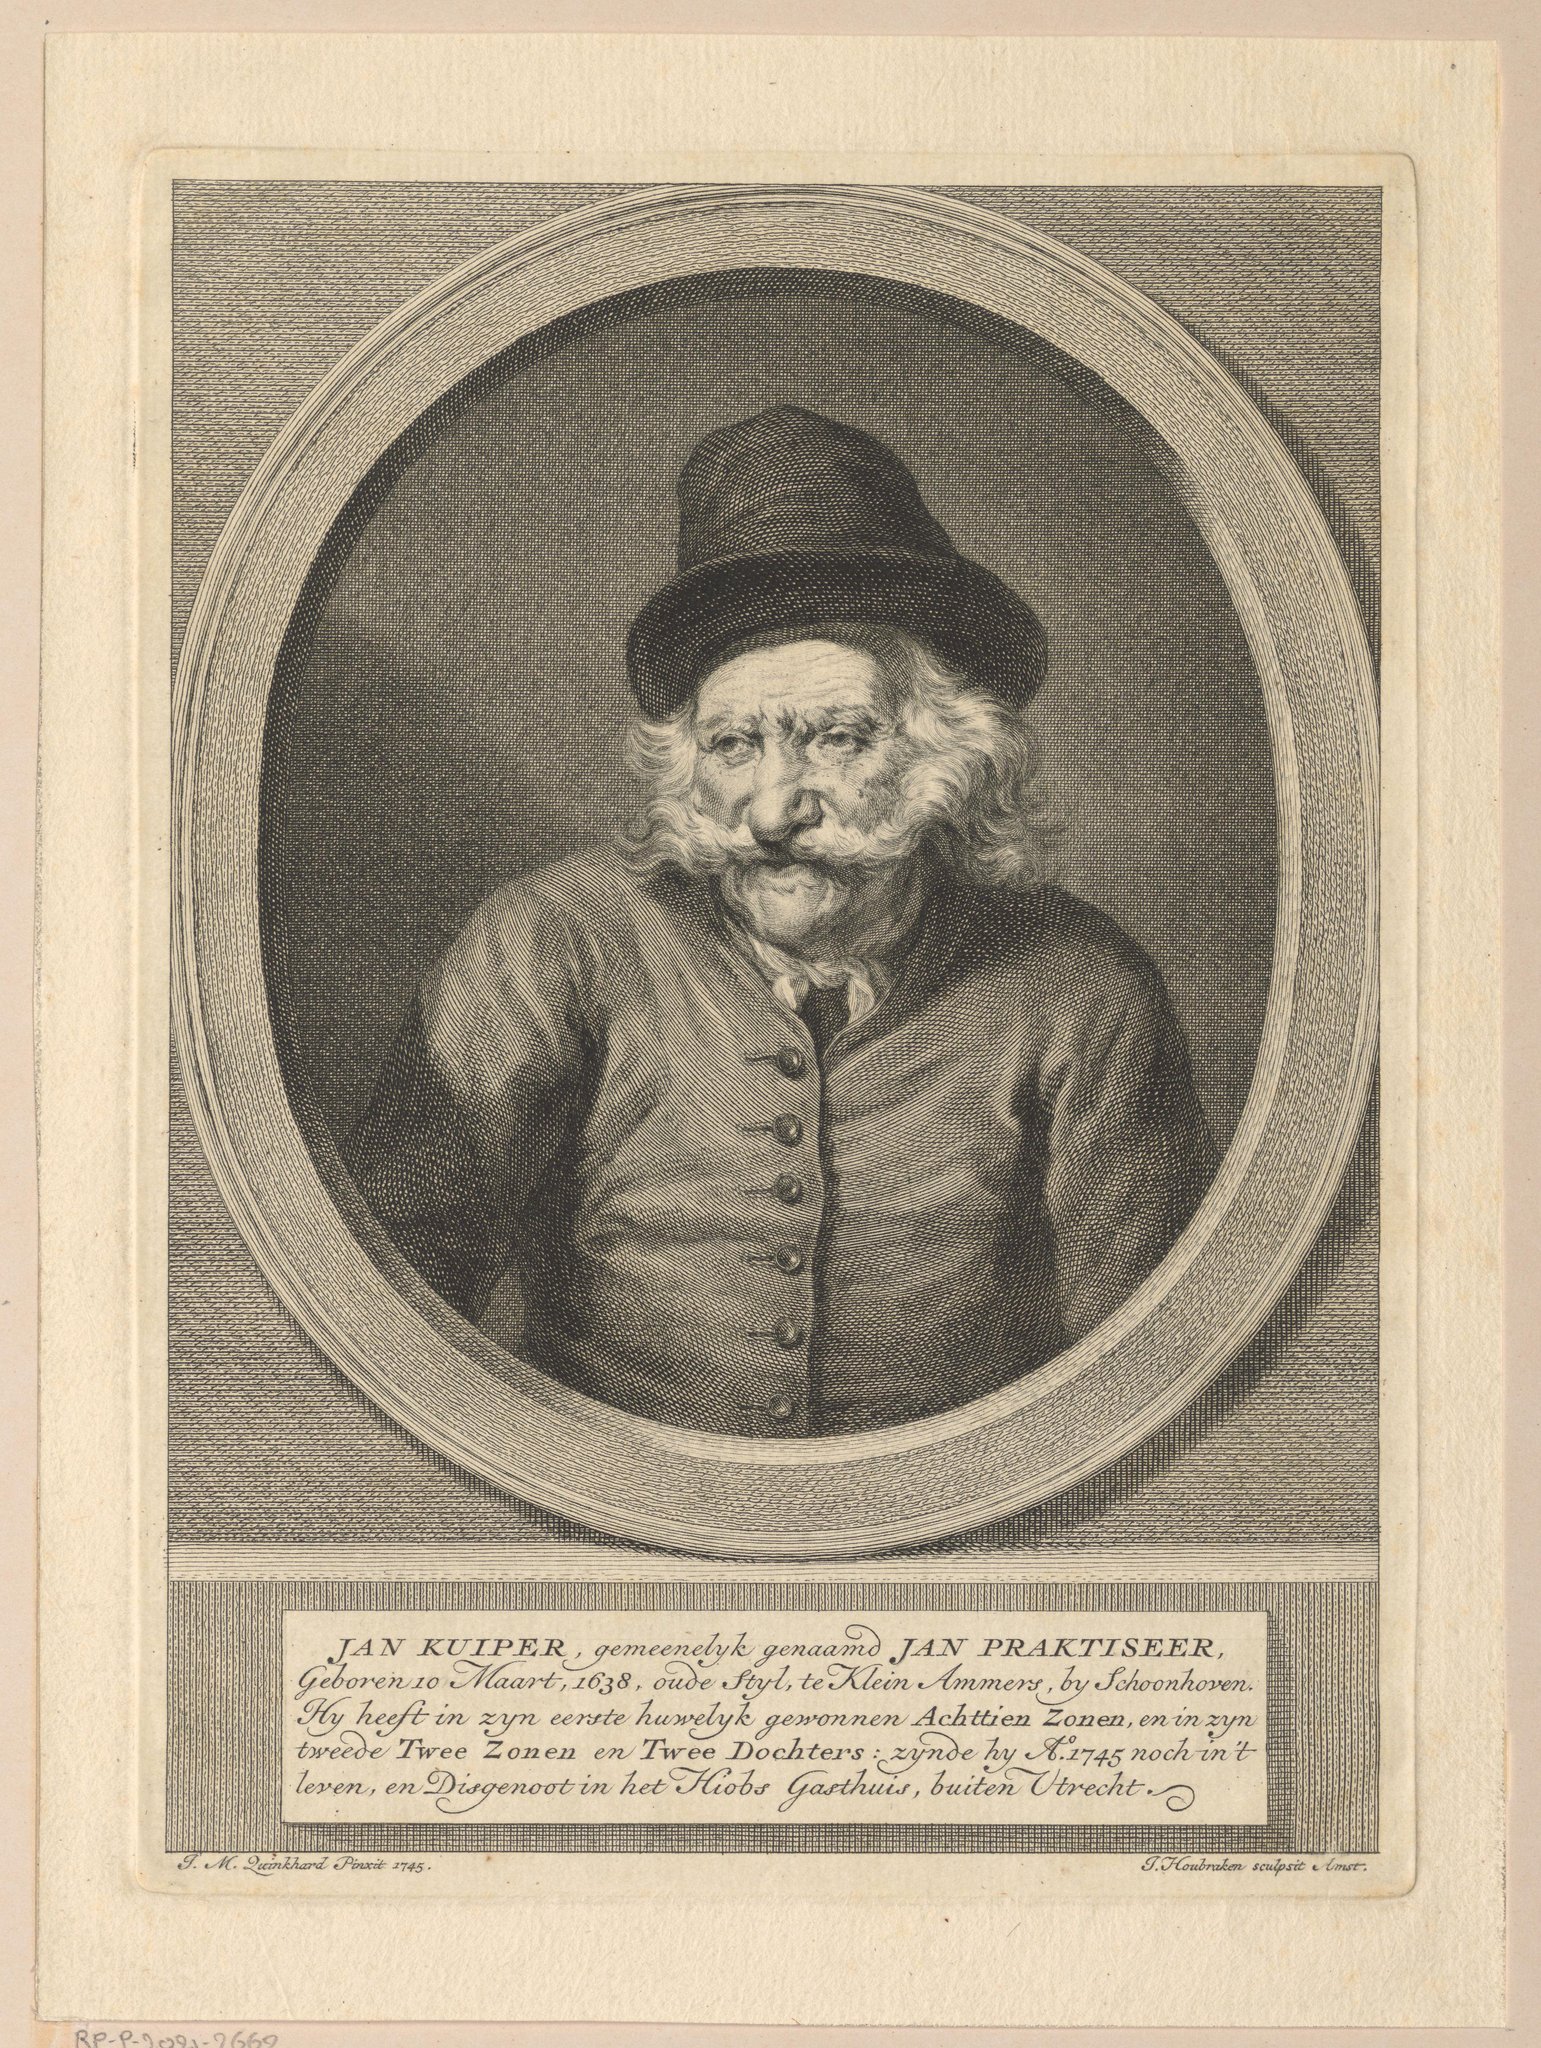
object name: print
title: Portret van Jan Kuiper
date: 1745-1780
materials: paper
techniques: engraving, etching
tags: historical persons